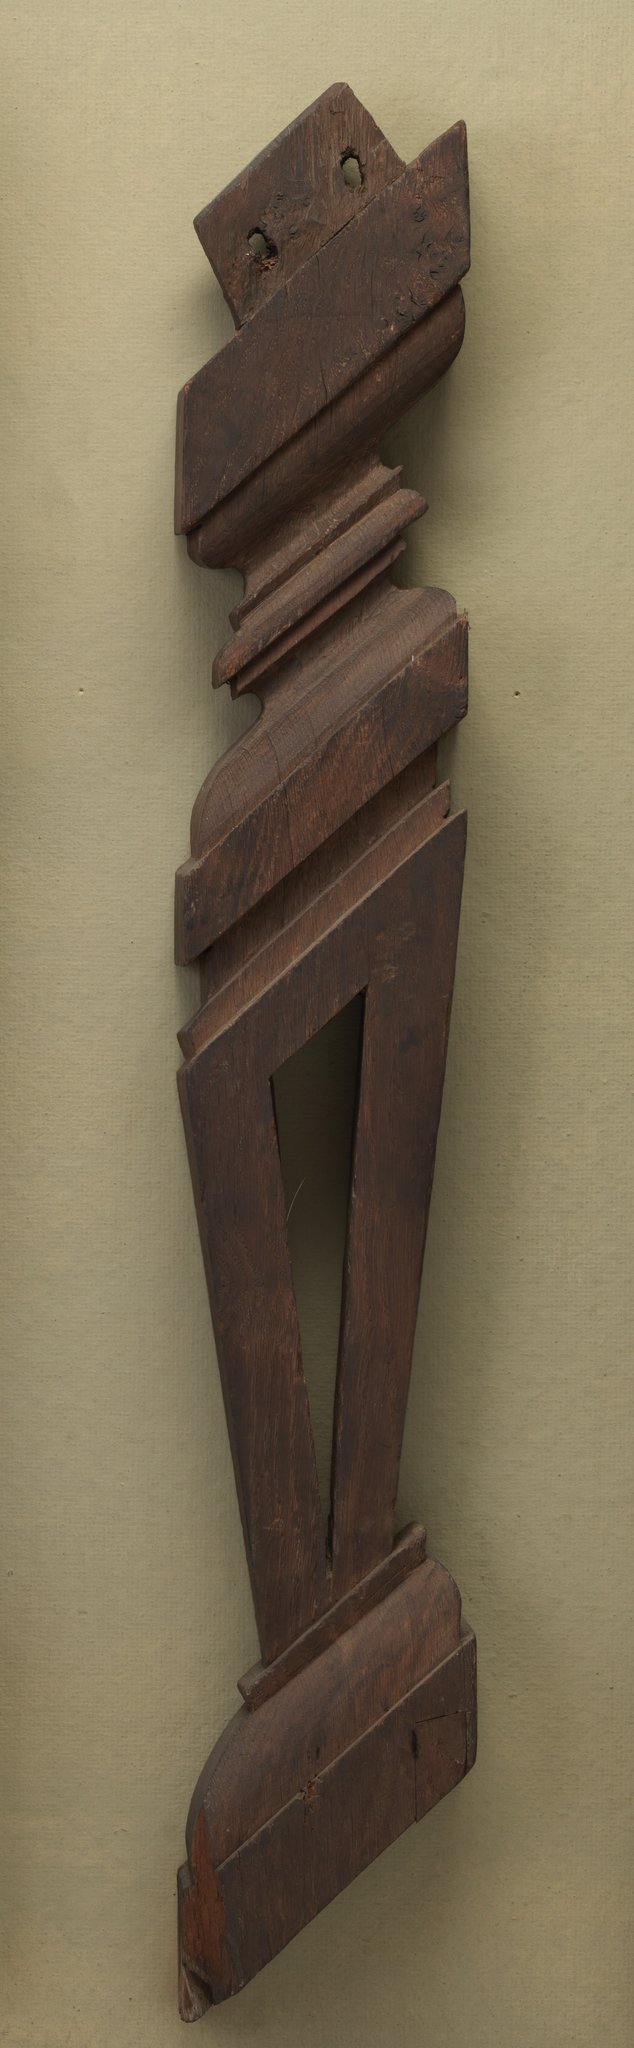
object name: baluster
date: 1601-1650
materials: wood